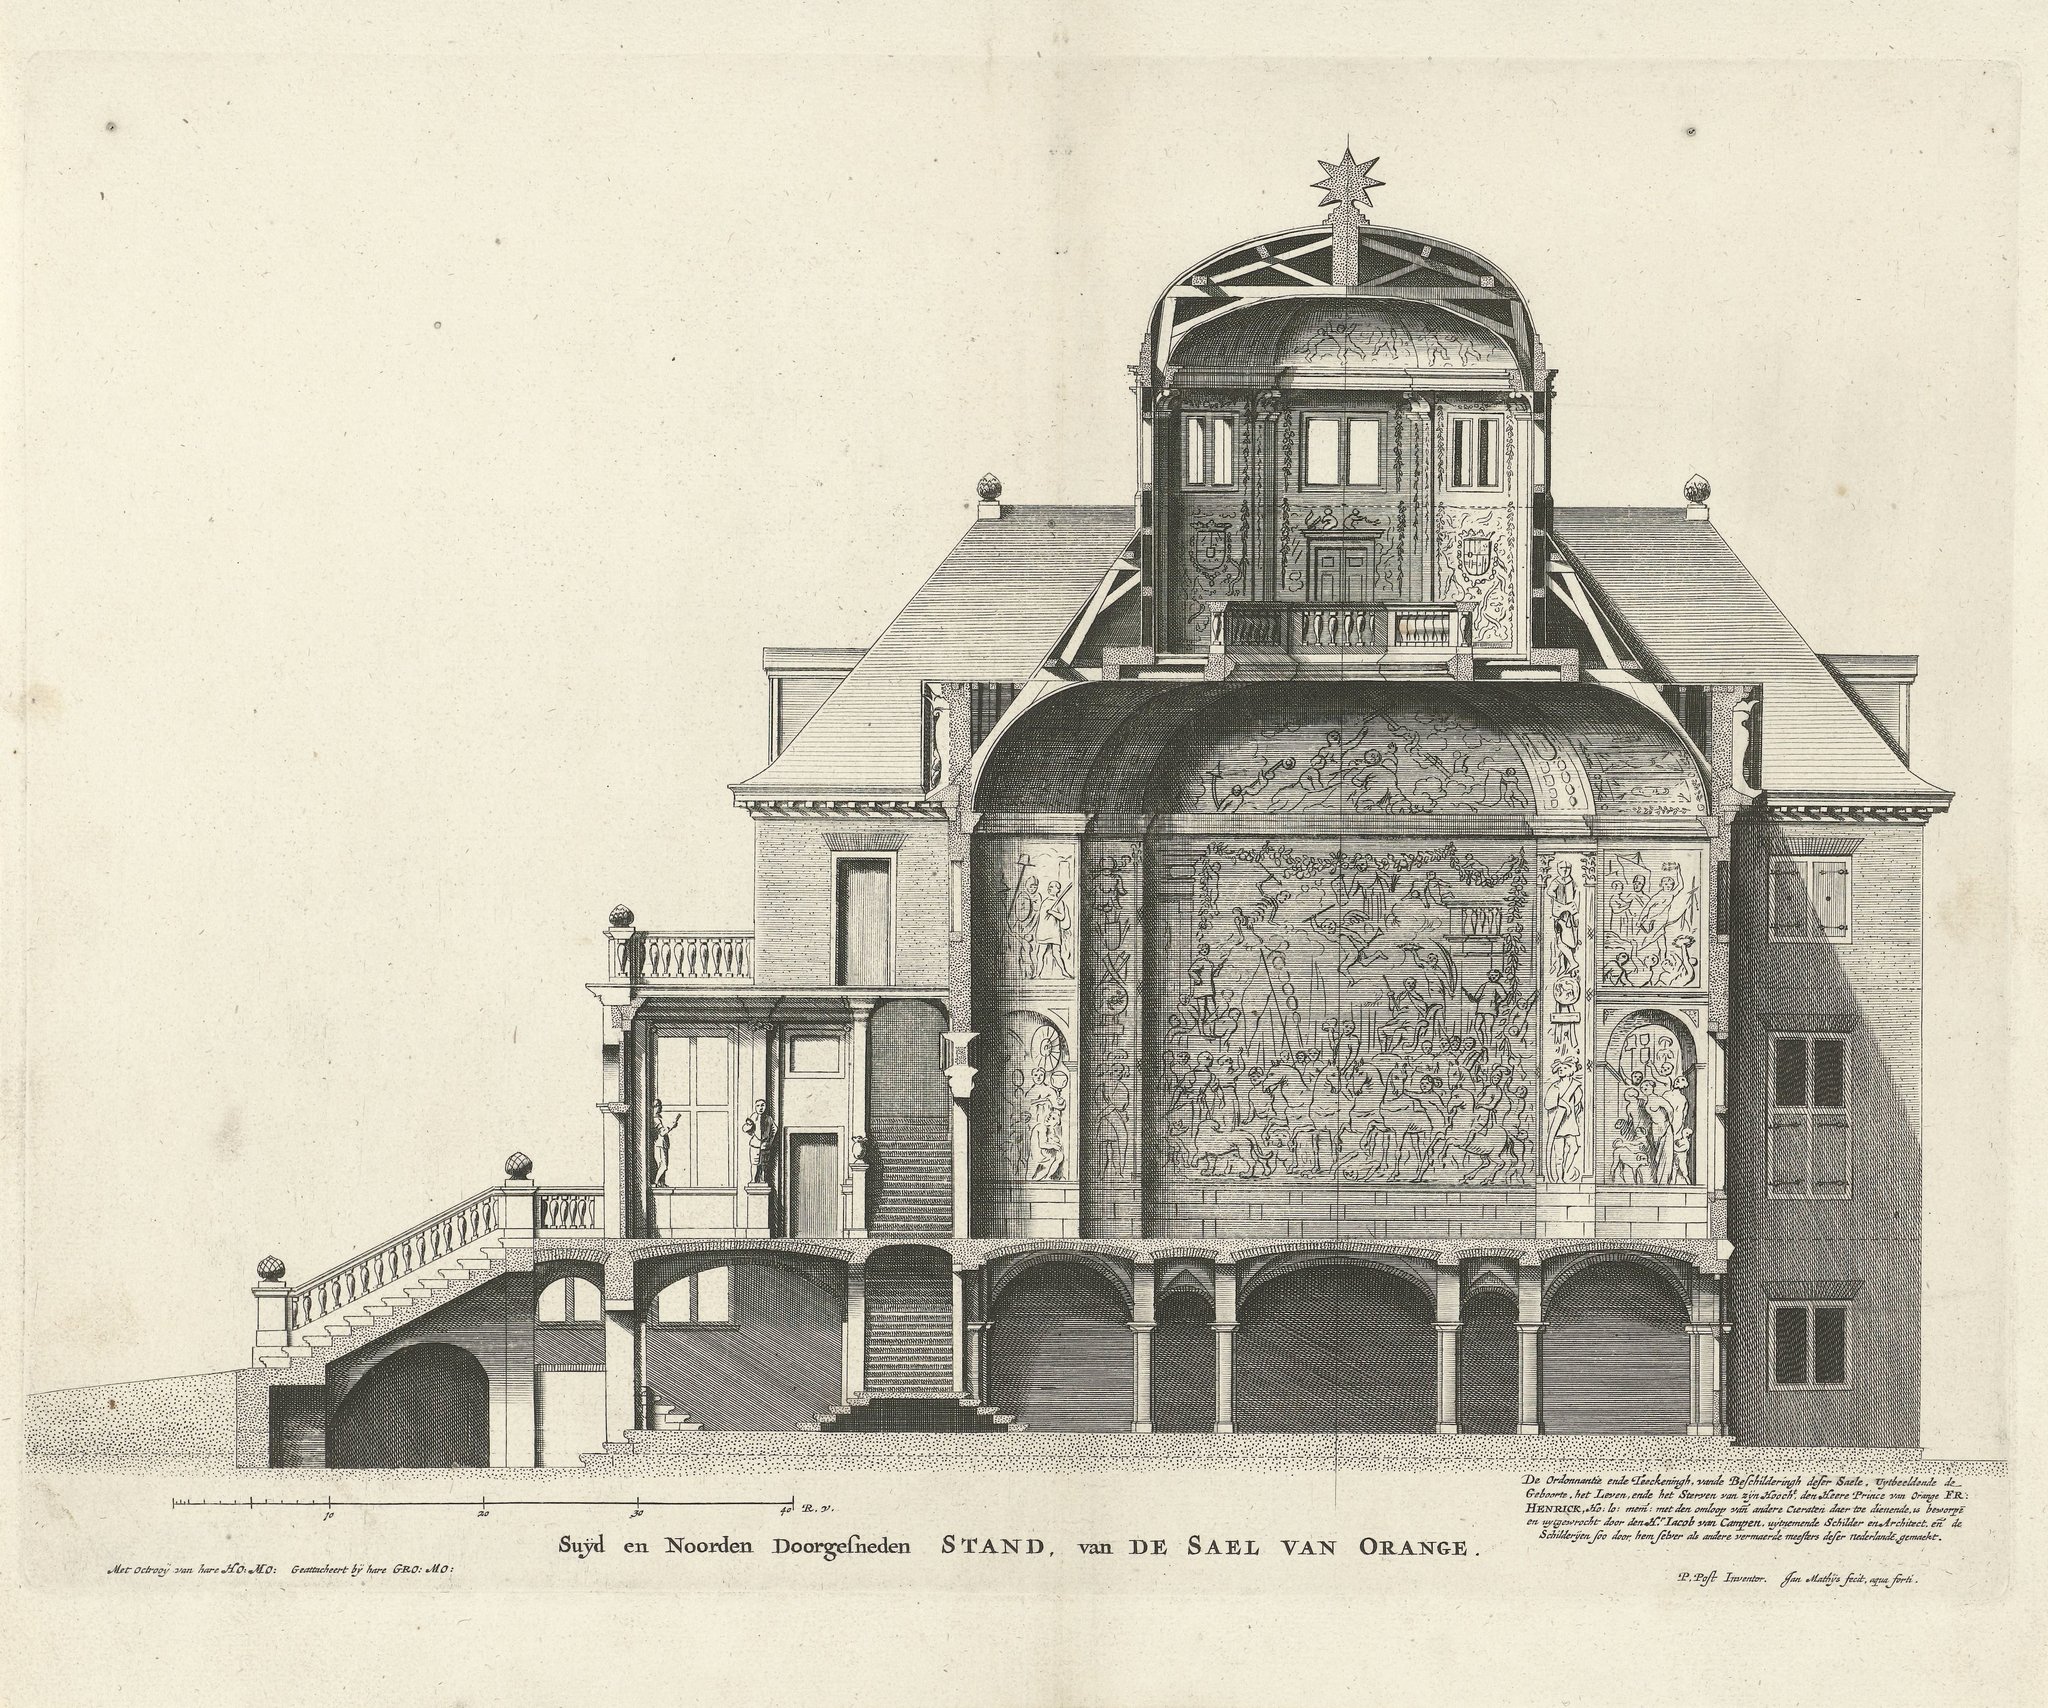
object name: print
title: Doorsnede van Paleis Huis ten Bosch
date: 1655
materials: paper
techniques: etching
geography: amsterdam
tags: palace, section ~ architectural design or model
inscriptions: collector's mark: Lugt 2228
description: Doorsnede van Paleis Huis ten Bosch te Den Haag met de schilderingen in de Oranje Zaal.